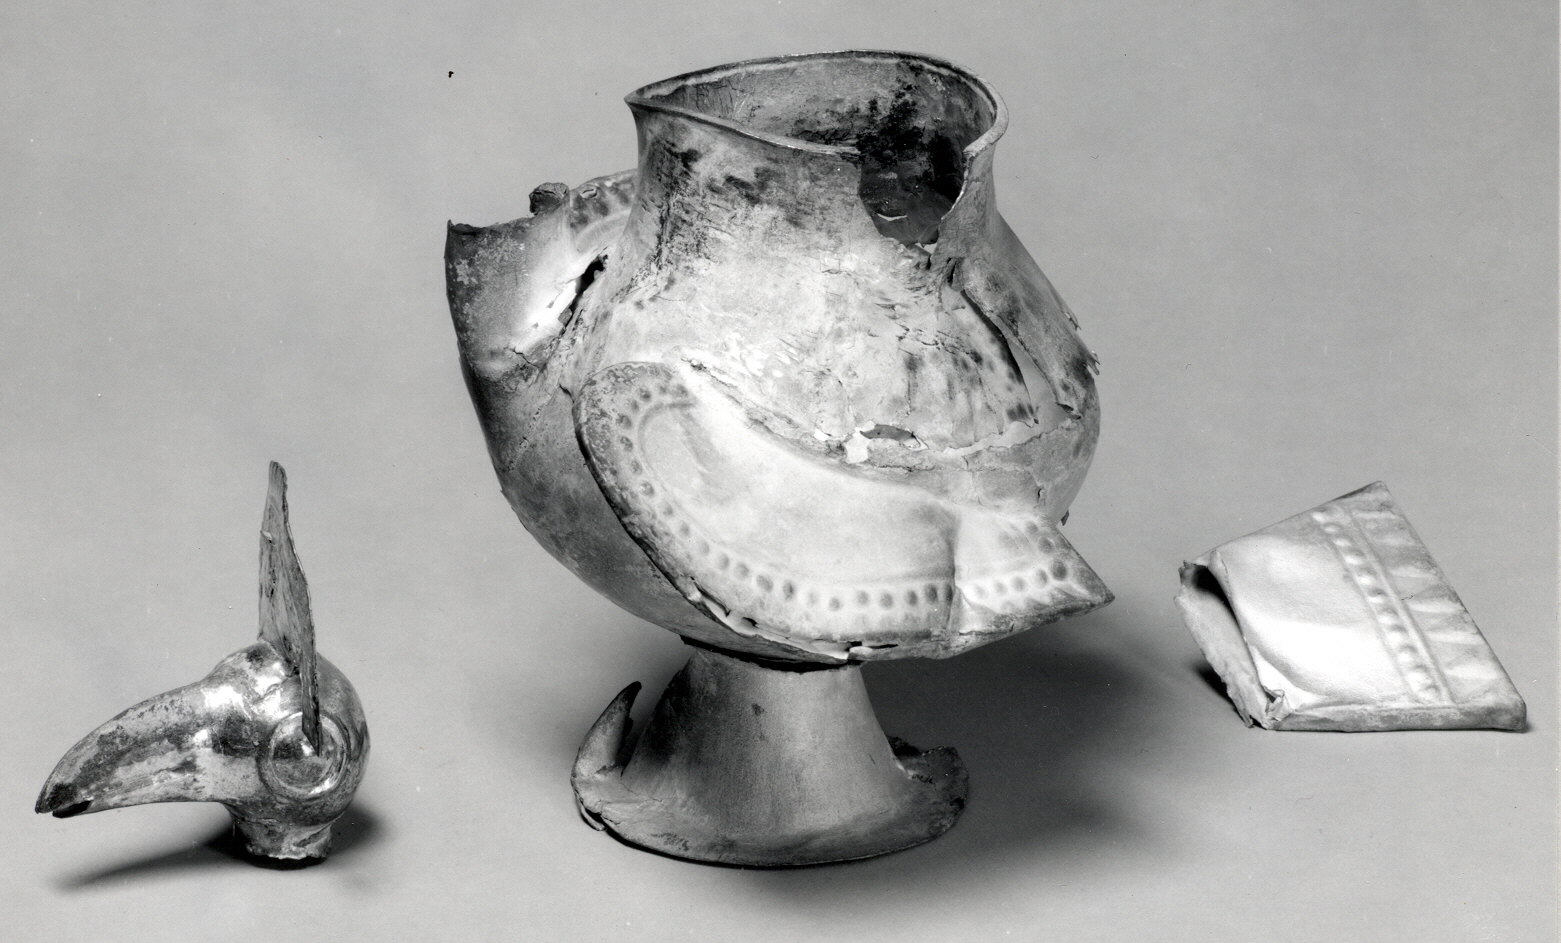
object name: vessel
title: Bird Vesel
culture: chimú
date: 1101-1500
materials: silver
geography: peru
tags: birds